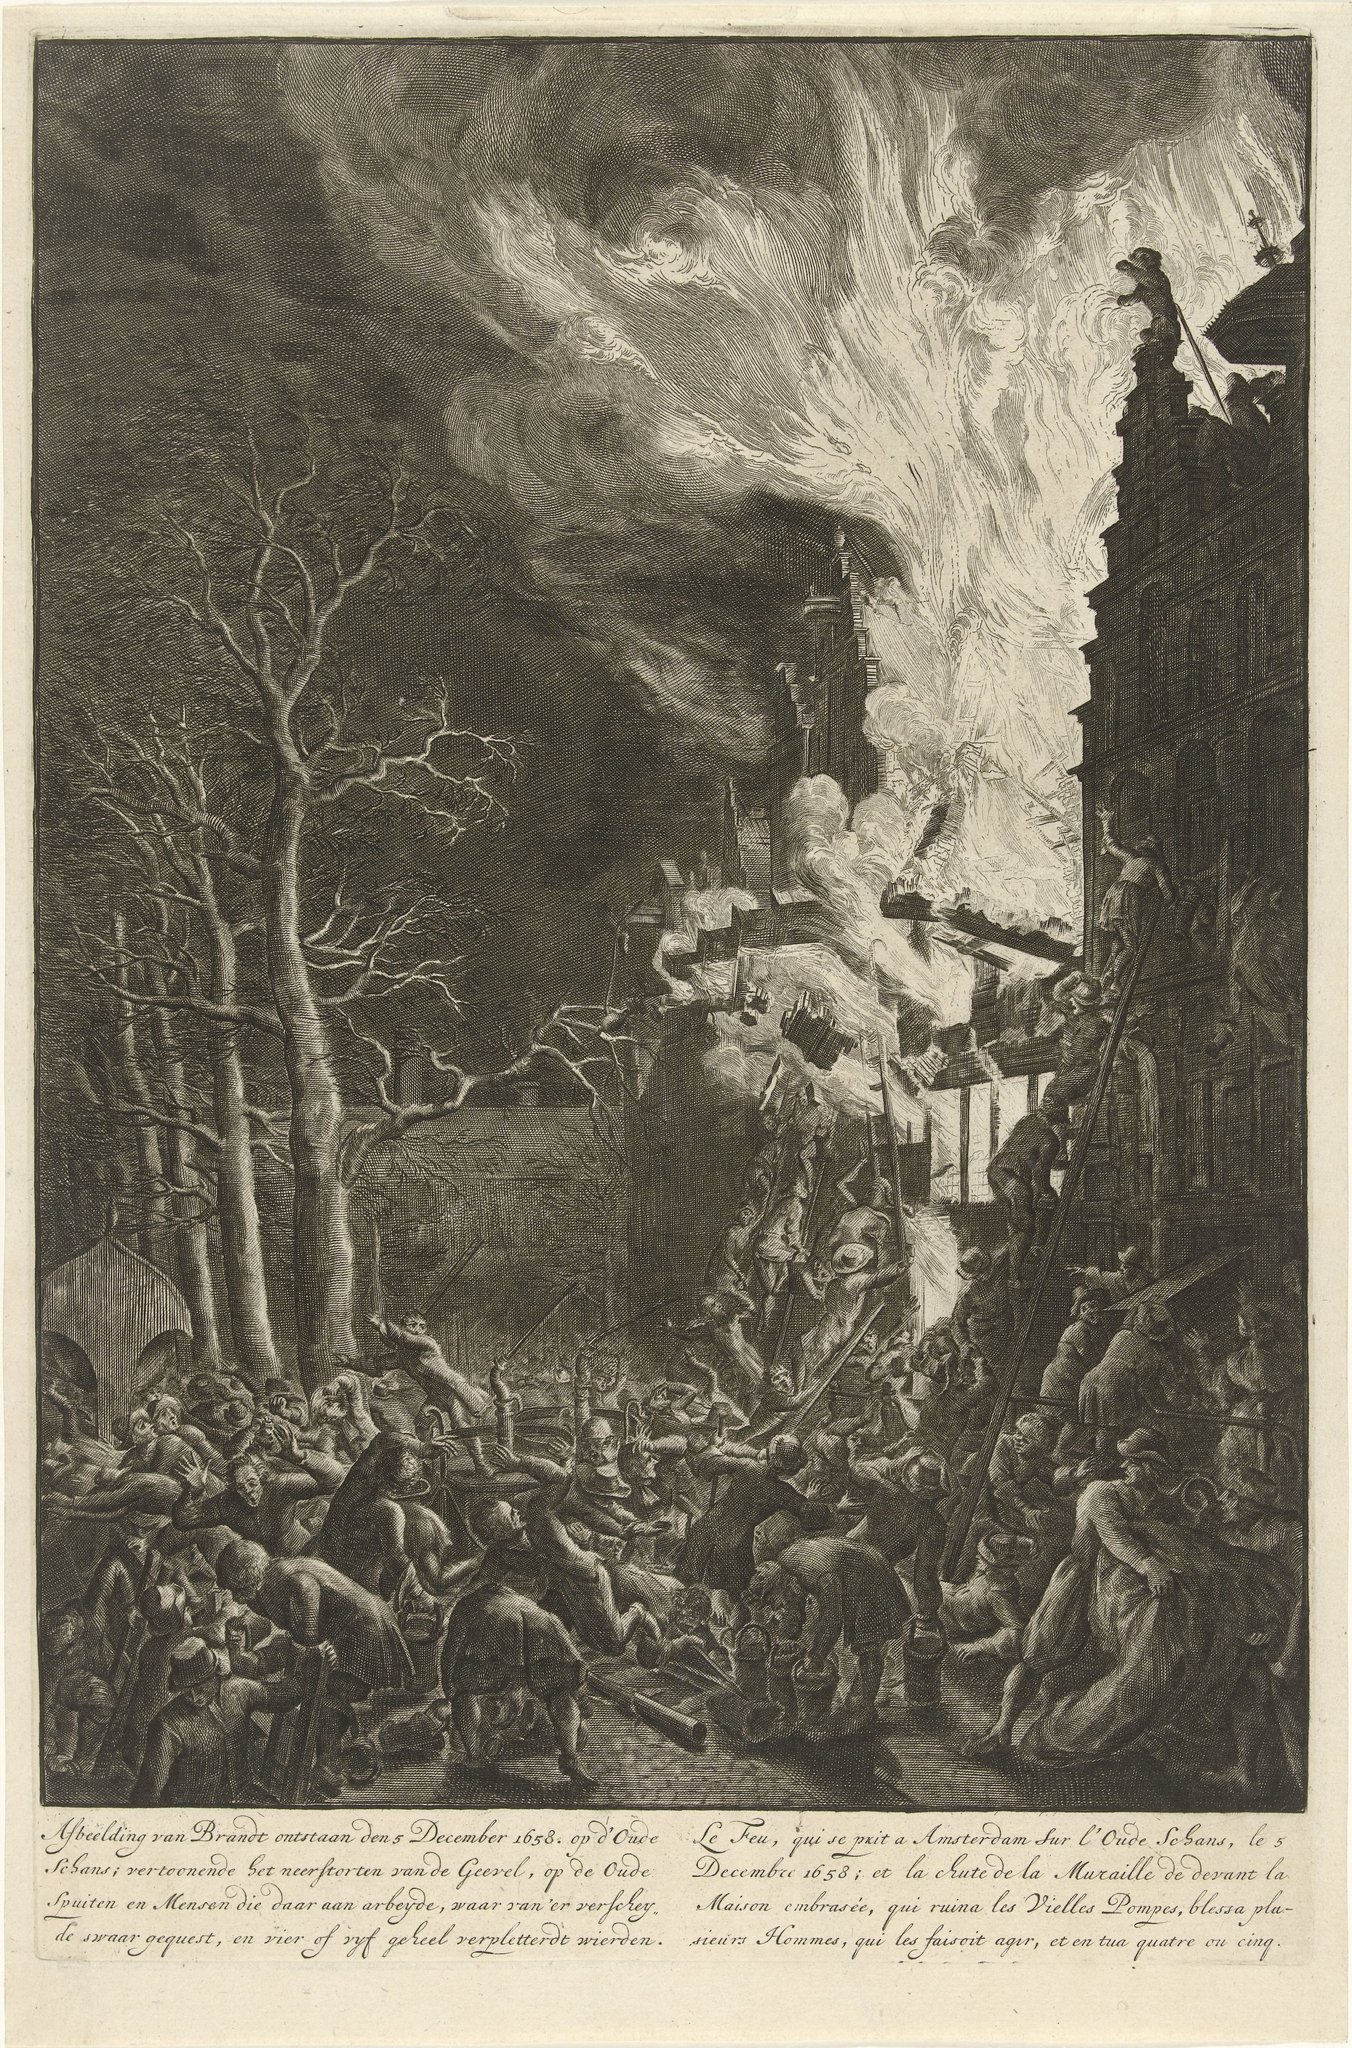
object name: book illustration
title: Afbeelding van brandt ontstaan den 5 december 1658. op d'Oude Schans (…) / Le feu, qui se prit a Amsterdam sur l'Oude Schans, le 5 decembre 1658 (…)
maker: jan van der heyden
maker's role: draughtsman, painter, print maker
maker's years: 1637-1712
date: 1690-1735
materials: paper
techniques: engraving, etching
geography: amsterdam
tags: painter, print maker, draughtsman, jan van der heyden, on fire, ablaze, fire-fighting, fire-extinguishing equipment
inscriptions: collector's mark: Lugt 2228, collector's mark: Lugt 2233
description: Prent ook gebruikt in: Heyden, Jan van der. Beschryving der nieuwlyks uitgevonden en geoctrojeerde slang-brand-spuiten en haare wyze van brand-blussen, tegenwoordig binnen Amsterdam in gebruik zijnde (…). 1e druk. Amsterdam: Jan Rieuwertsz. (II), 1690. En in: Heyden, Jan van der. Beschryving der nieuwlyks uitgevonden en geoctrojeerde slang-brand-spuiten en haare wyze van brand-blussen, tegenwoordig binnen Amsterdam in gebruik zijnde (…). 2e druk. Amsterdam: erfgenamen Jan van der Heyden, 1735.